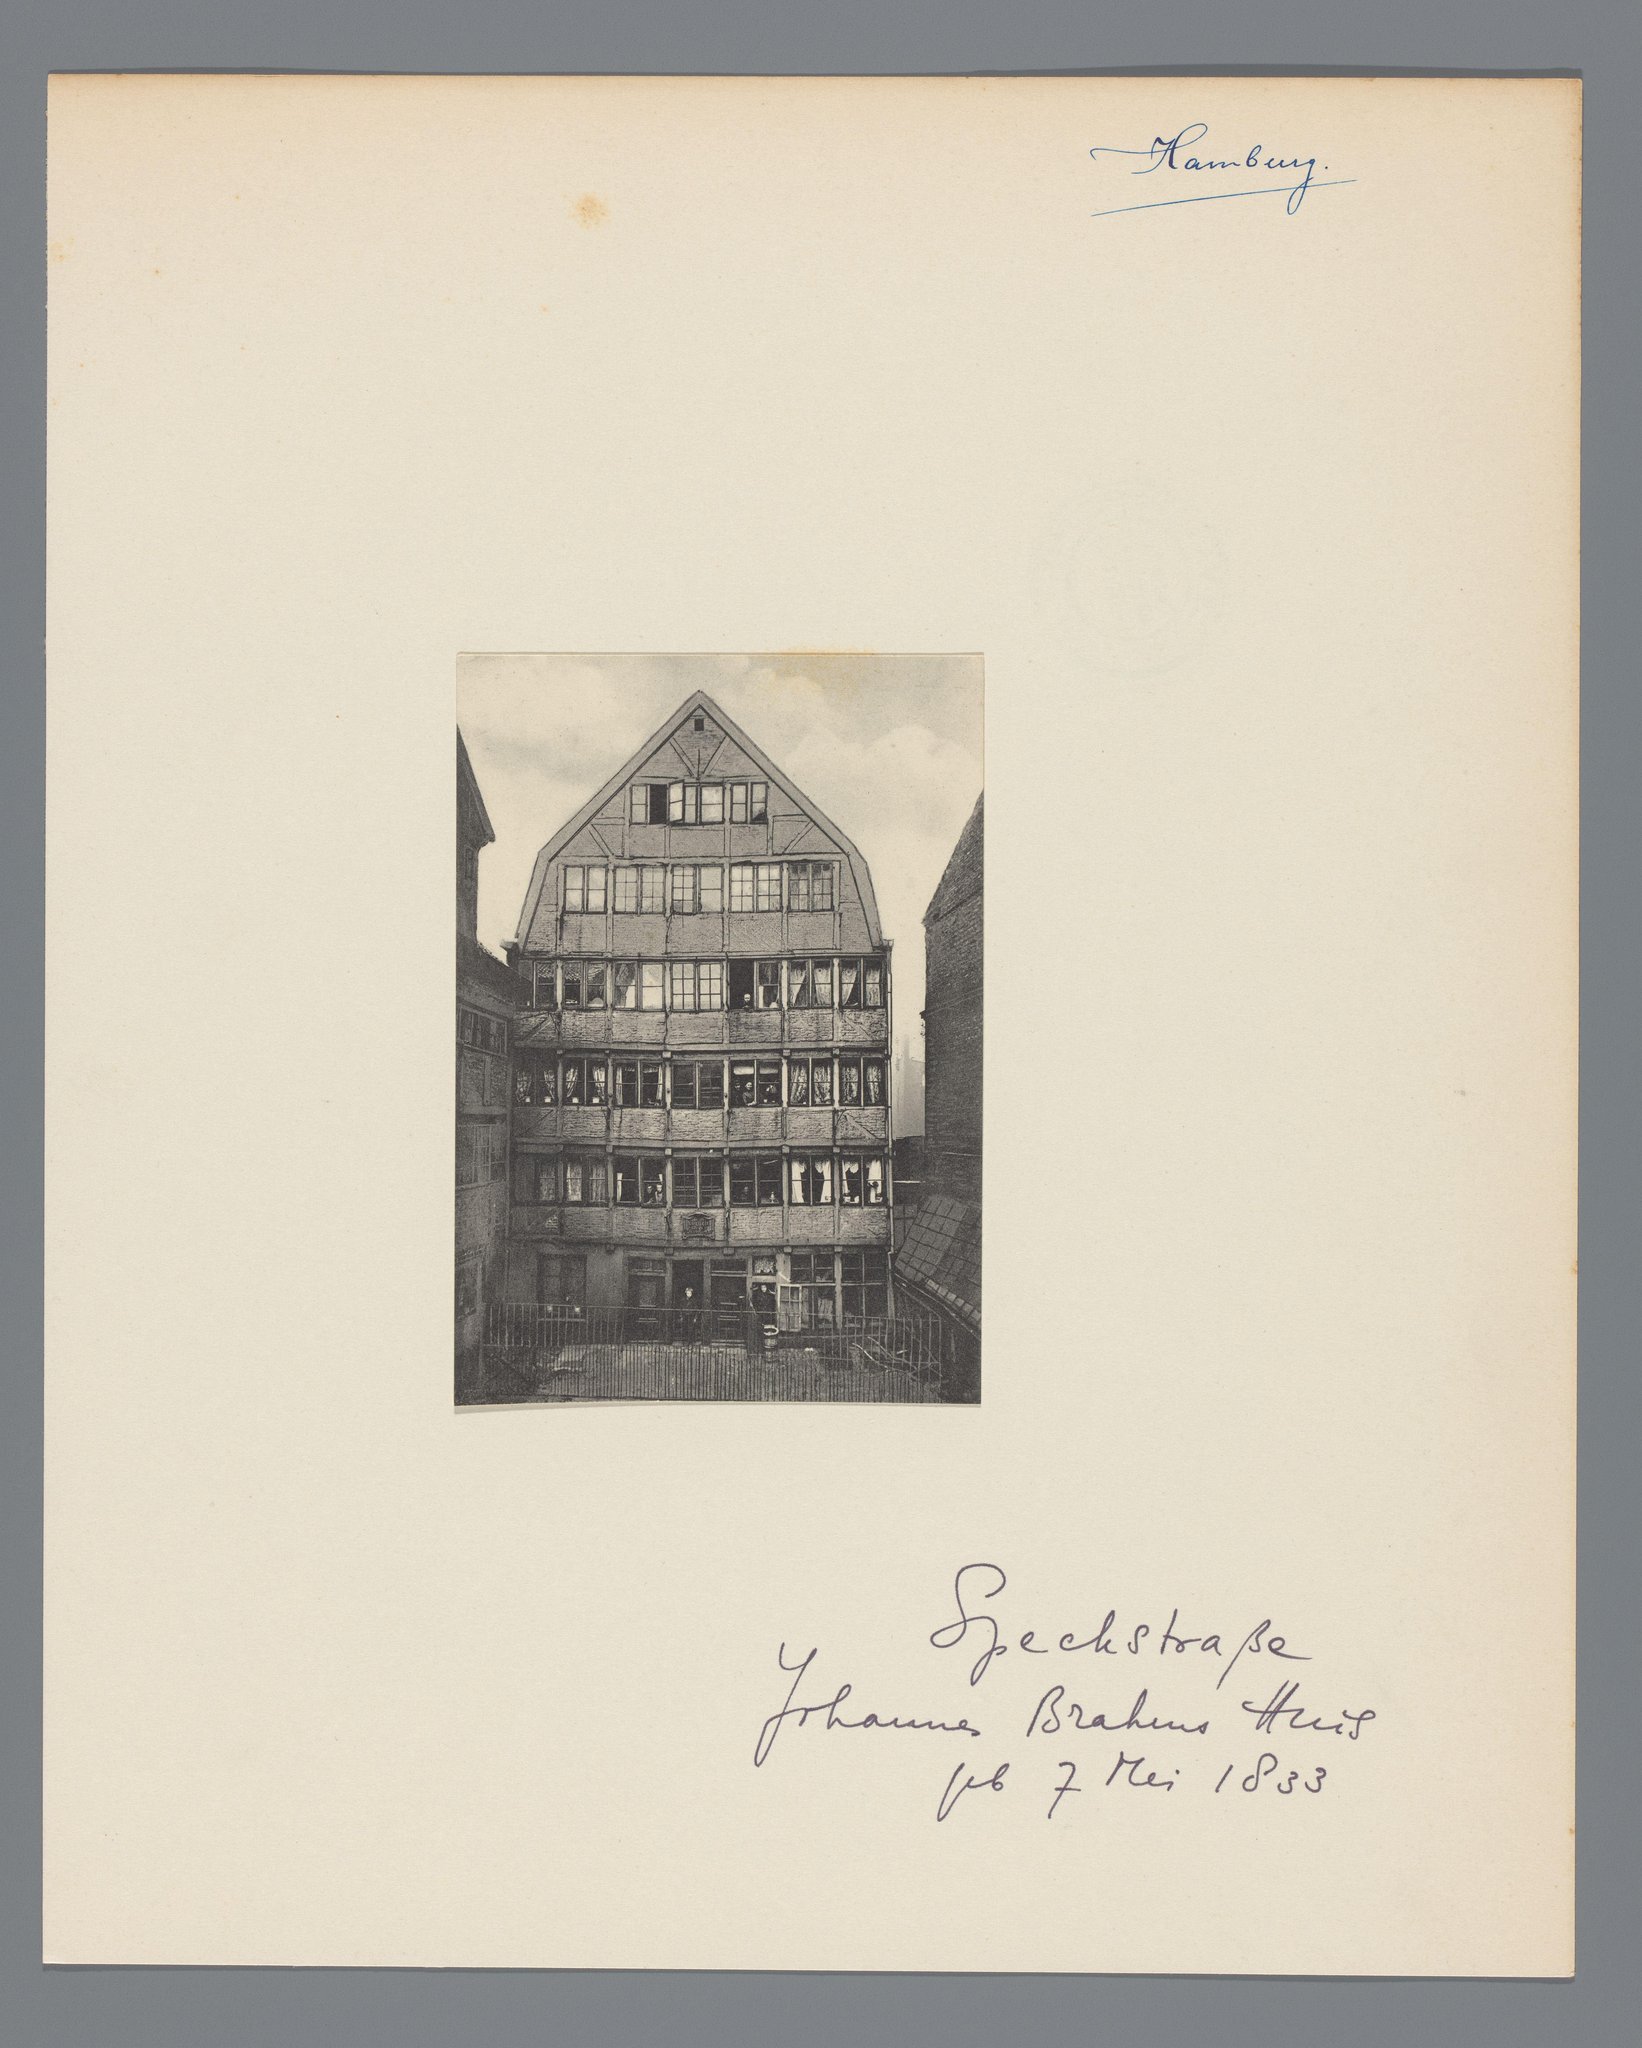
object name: photograph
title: Hamburg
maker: Anonymous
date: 1880-1920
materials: photographic support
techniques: photograph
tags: hamburg